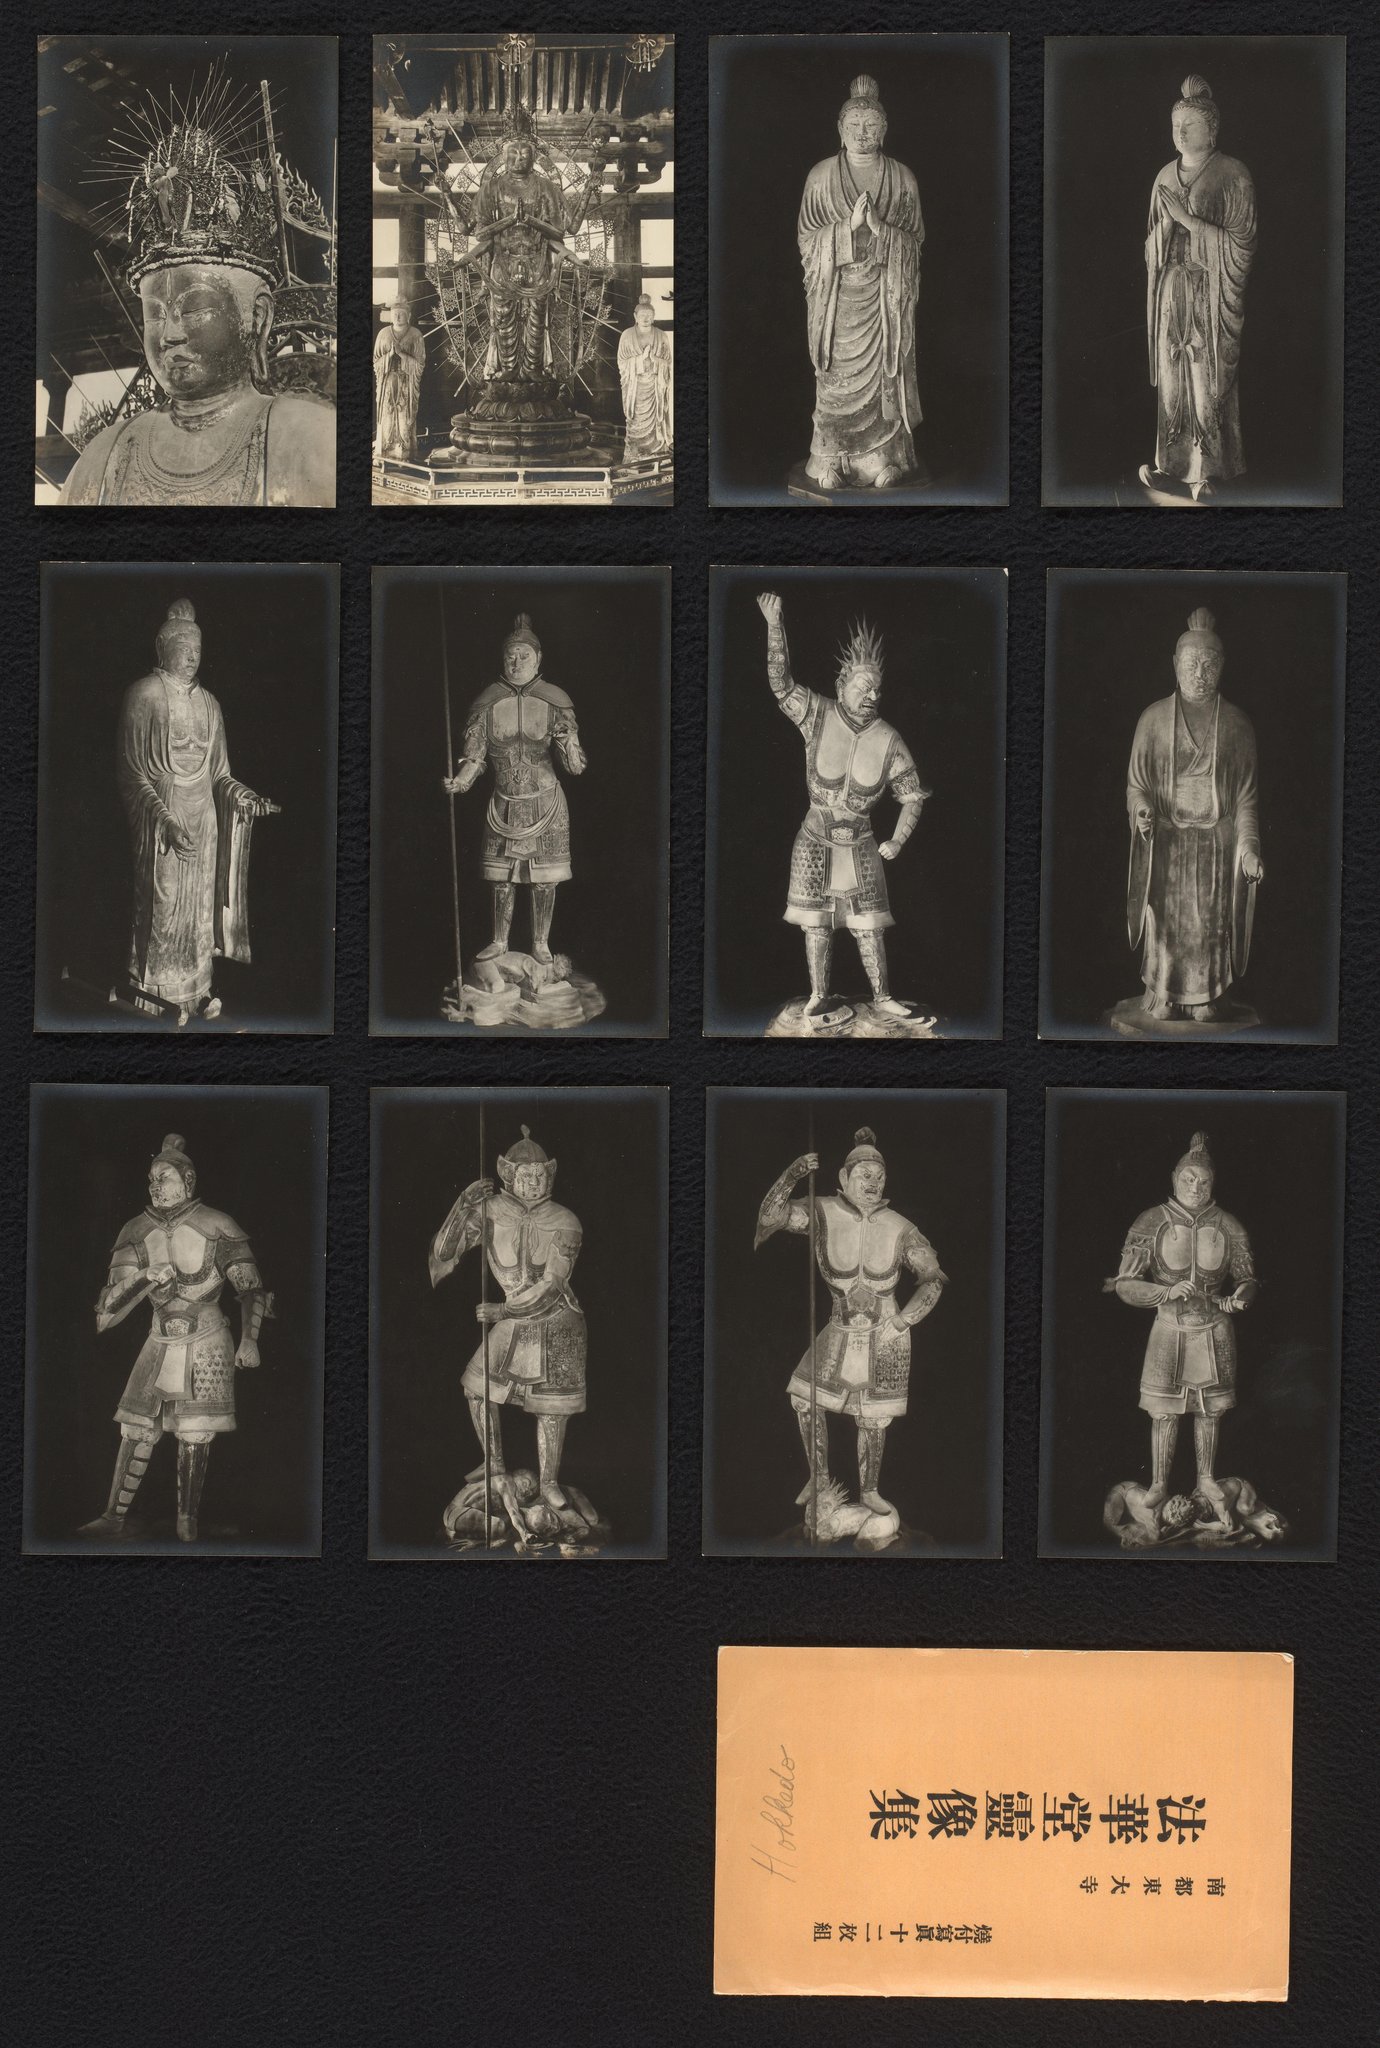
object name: photograph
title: Prentbriefkaarten van standbeelden in Hokke-dō op het Tōdai-ji-complex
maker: Anonymous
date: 1925-1940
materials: paper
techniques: gelatin silver print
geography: nara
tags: temple, shrine ~ shinto, piece of sculpture, reproduction of a piece of sculpture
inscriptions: inscription: ‘Hokkedo’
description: Twaalf prentbriefkaarten van standbeelden in Hokke-dō op het Tōdai-ji-complex in een envelop.